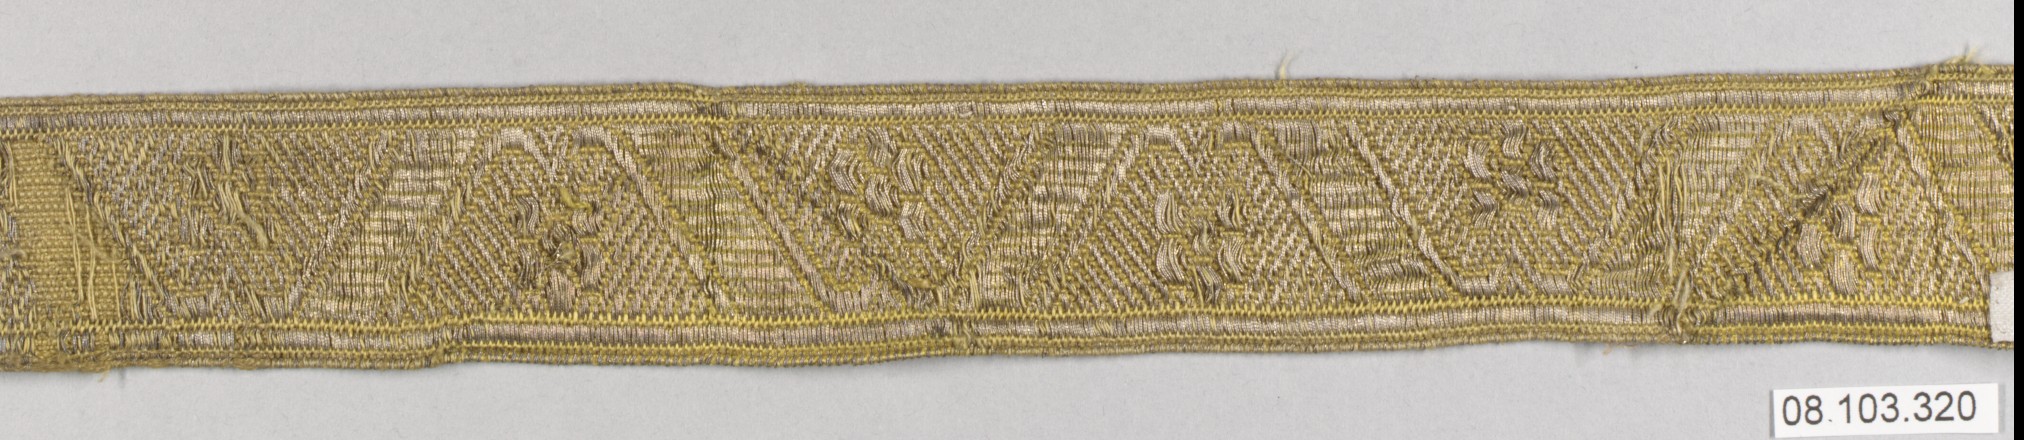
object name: galloon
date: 1601-1800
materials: metal thread, silk